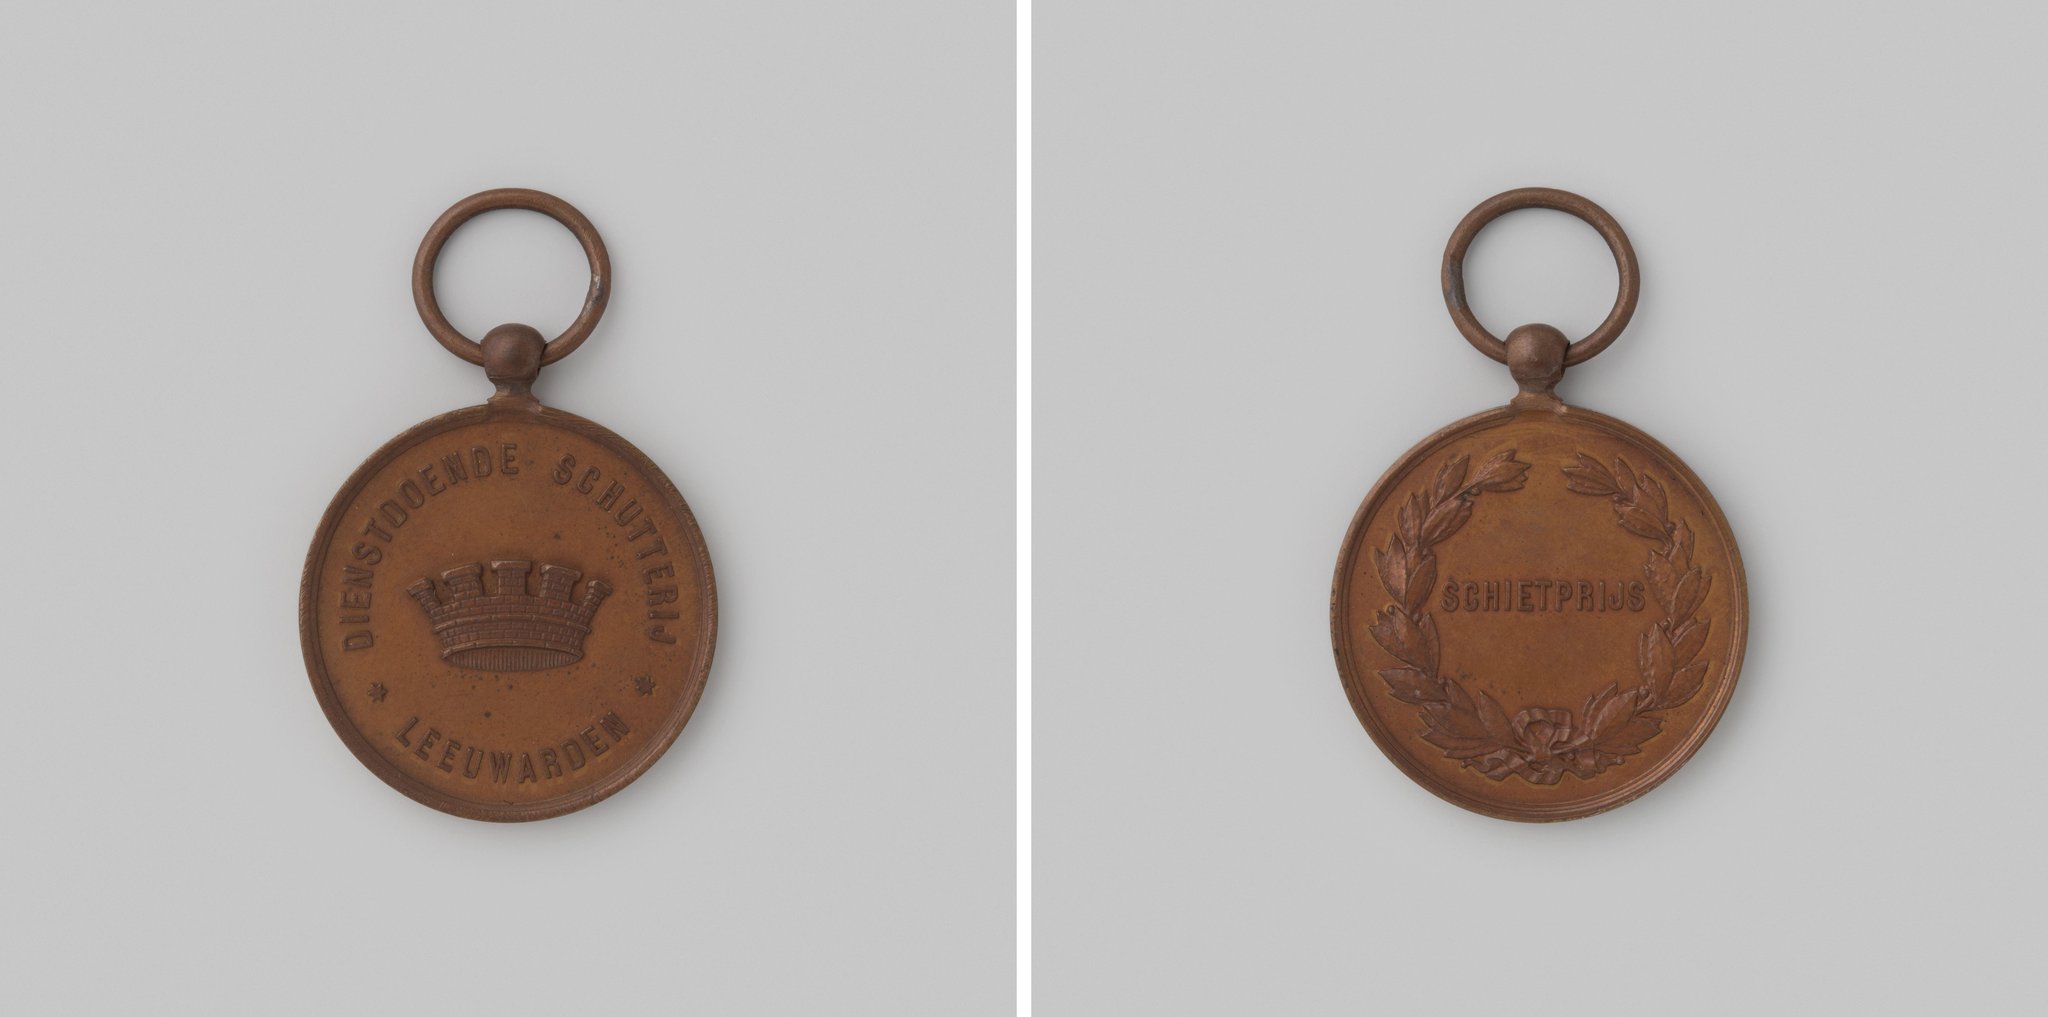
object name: medal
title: Schietprijs voor dienstdoende schutterij Leeuwarden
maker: Anonymous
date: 1800-1920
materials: metal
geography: leeuwarden